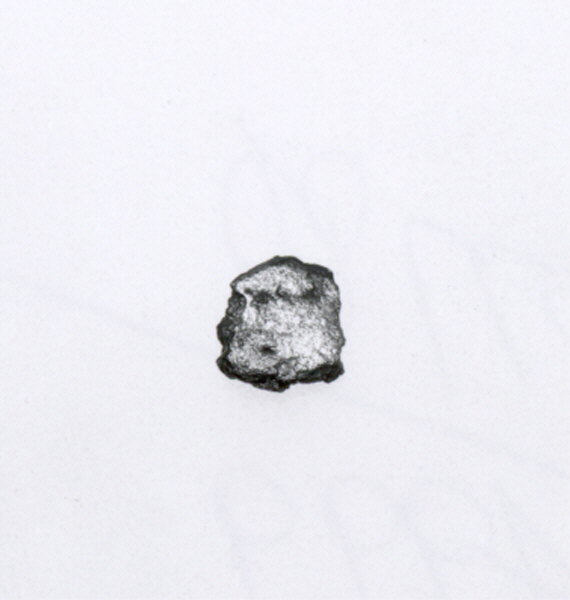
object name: silver ore lump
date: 2333-2001 BCE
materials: silver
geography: mesopotamia